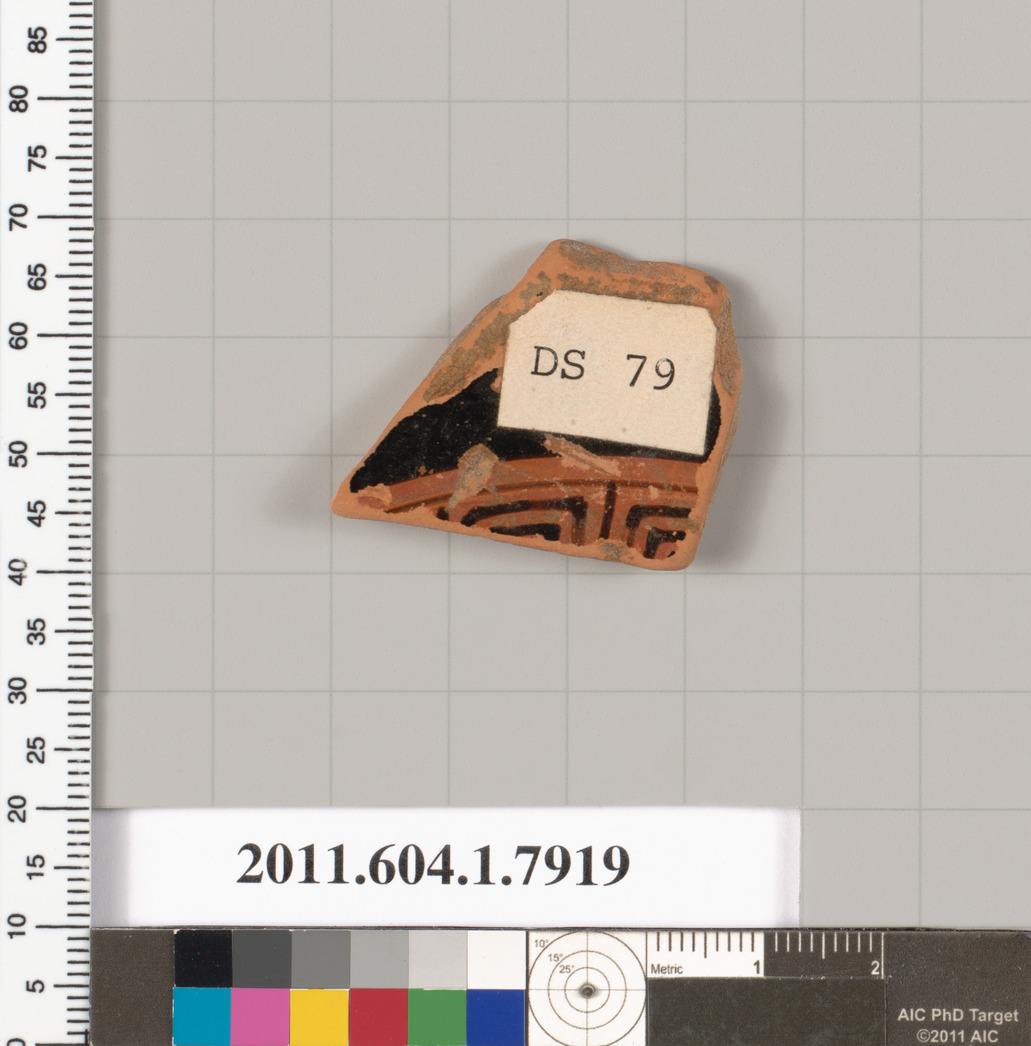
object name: kylix fragment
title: Terracotta fragment of a kylix (drinking cup)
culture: greek, attic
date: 460-450 BCE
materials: terracotta